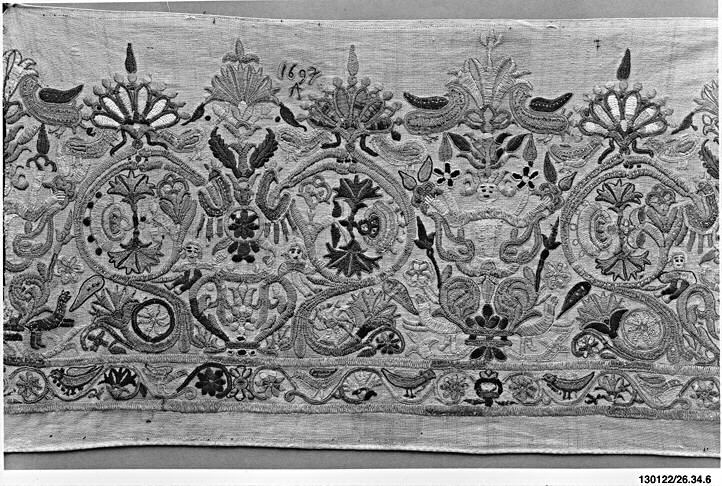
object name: border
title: Dress border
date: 1697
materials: linen, silk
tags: birds,flowers